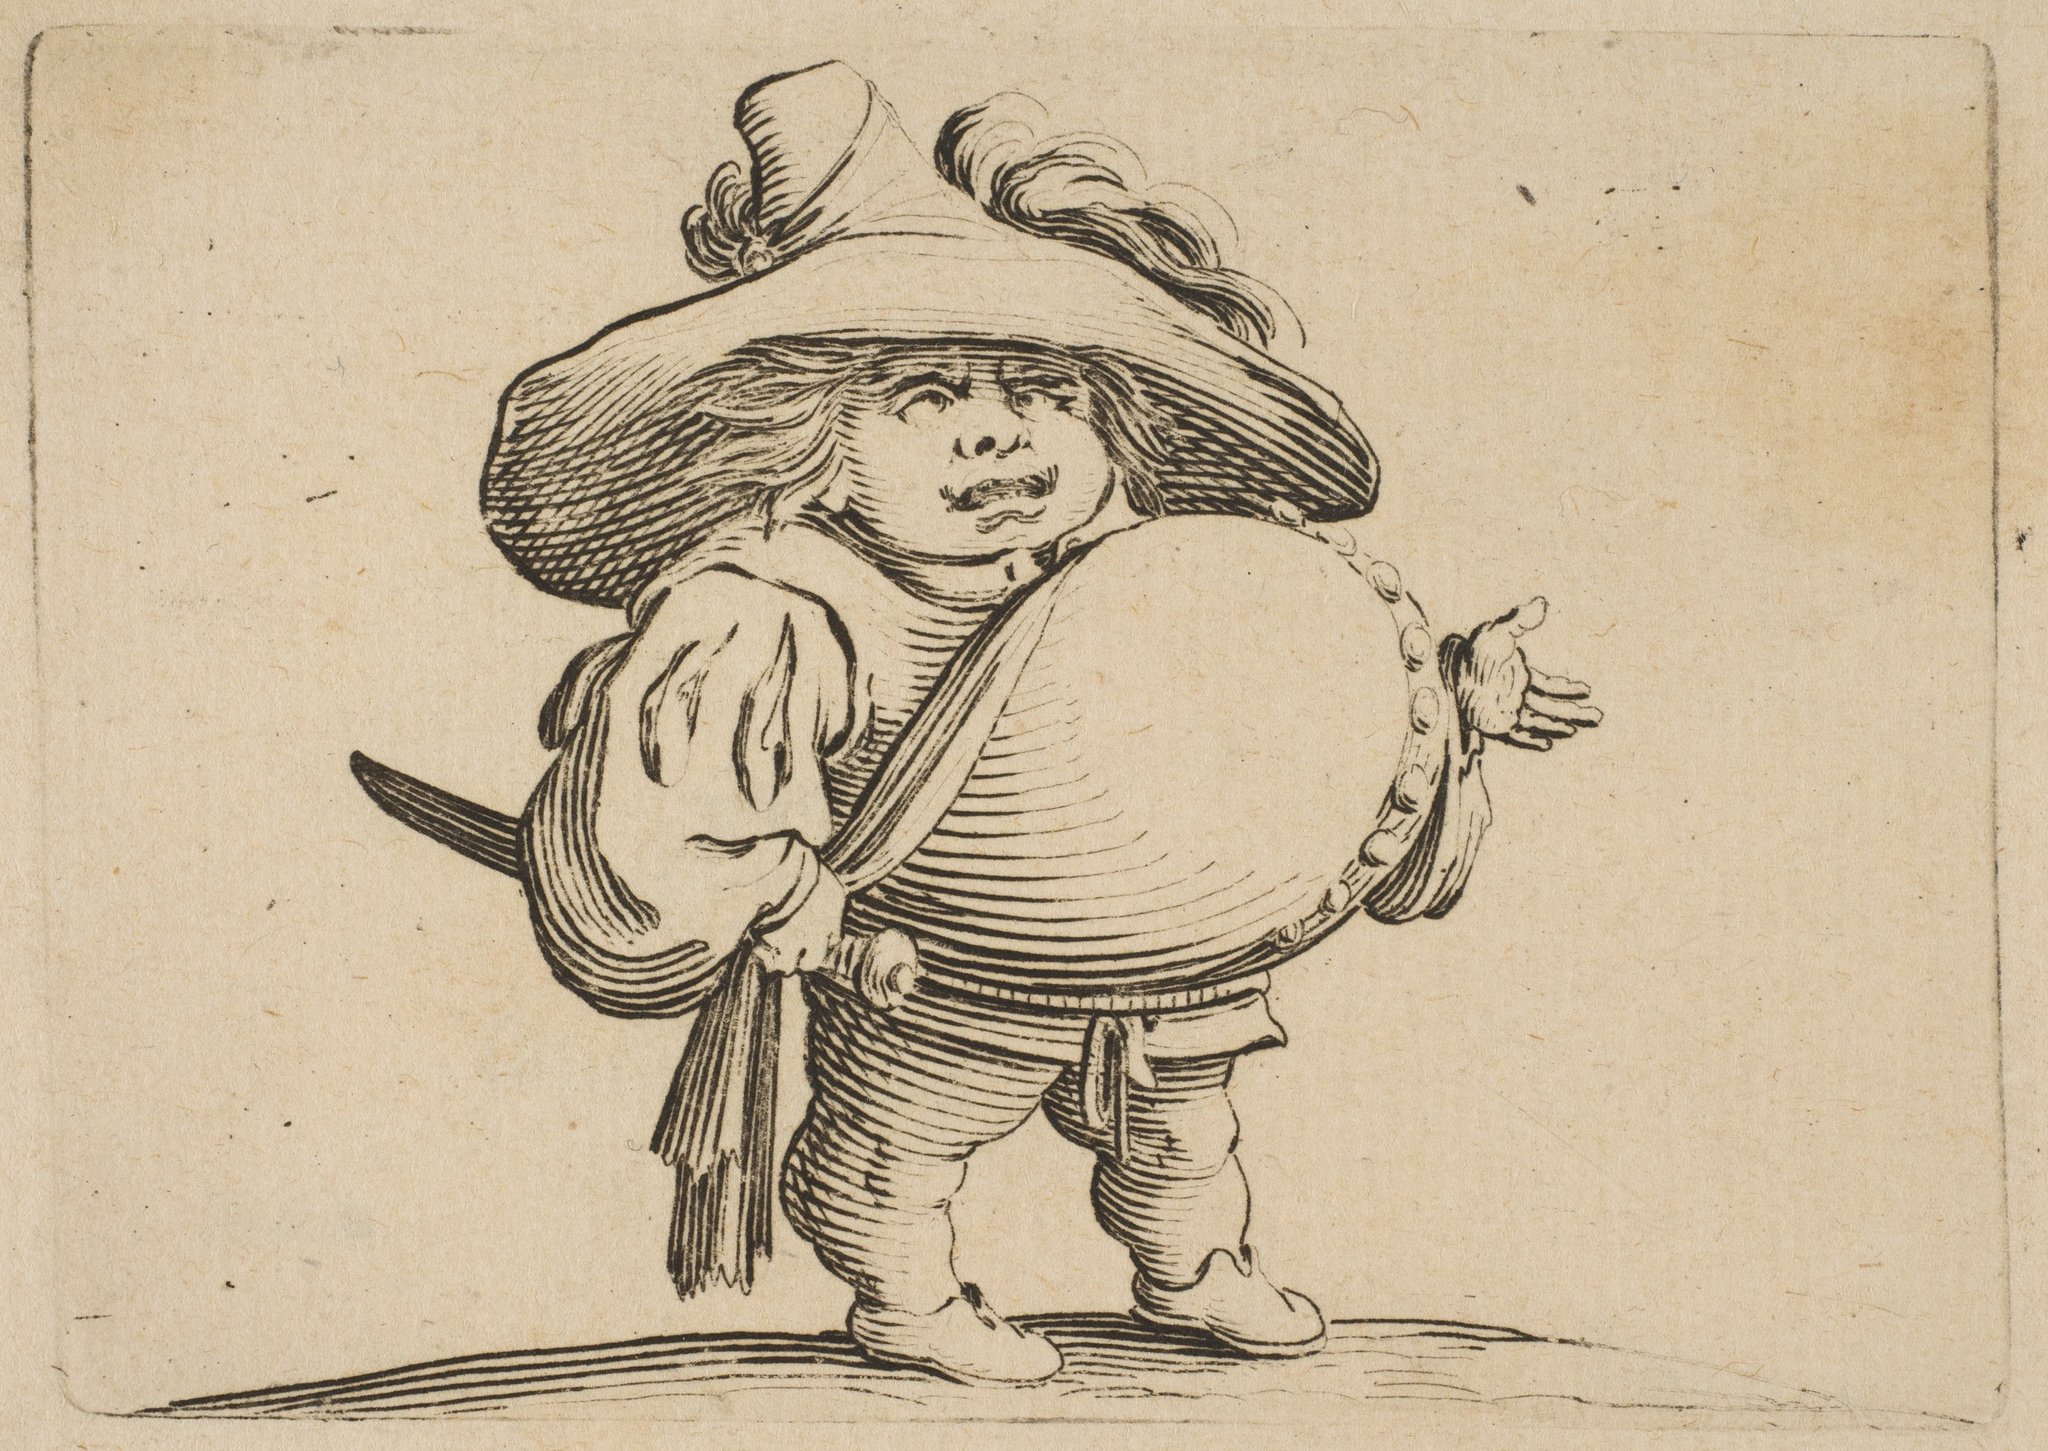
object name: print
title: L'Homme au Gros Ventre Orné d'une Rangée de Boutons (Man with a Large Belly Decorated with a Row of Buttons), from "Varie Figure Gobbi, suite appelée aussi Les Bossus, Les Pygmées, Les Nains Grotesques" (Various Hunchbacked Figures, The Hunchbacks, The Pygmes, The Grotesque Dwarfs)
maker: jacques callot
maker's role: artist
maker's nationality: french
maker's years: 1592-1635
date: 1616-1622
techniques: engraving, etching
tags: men